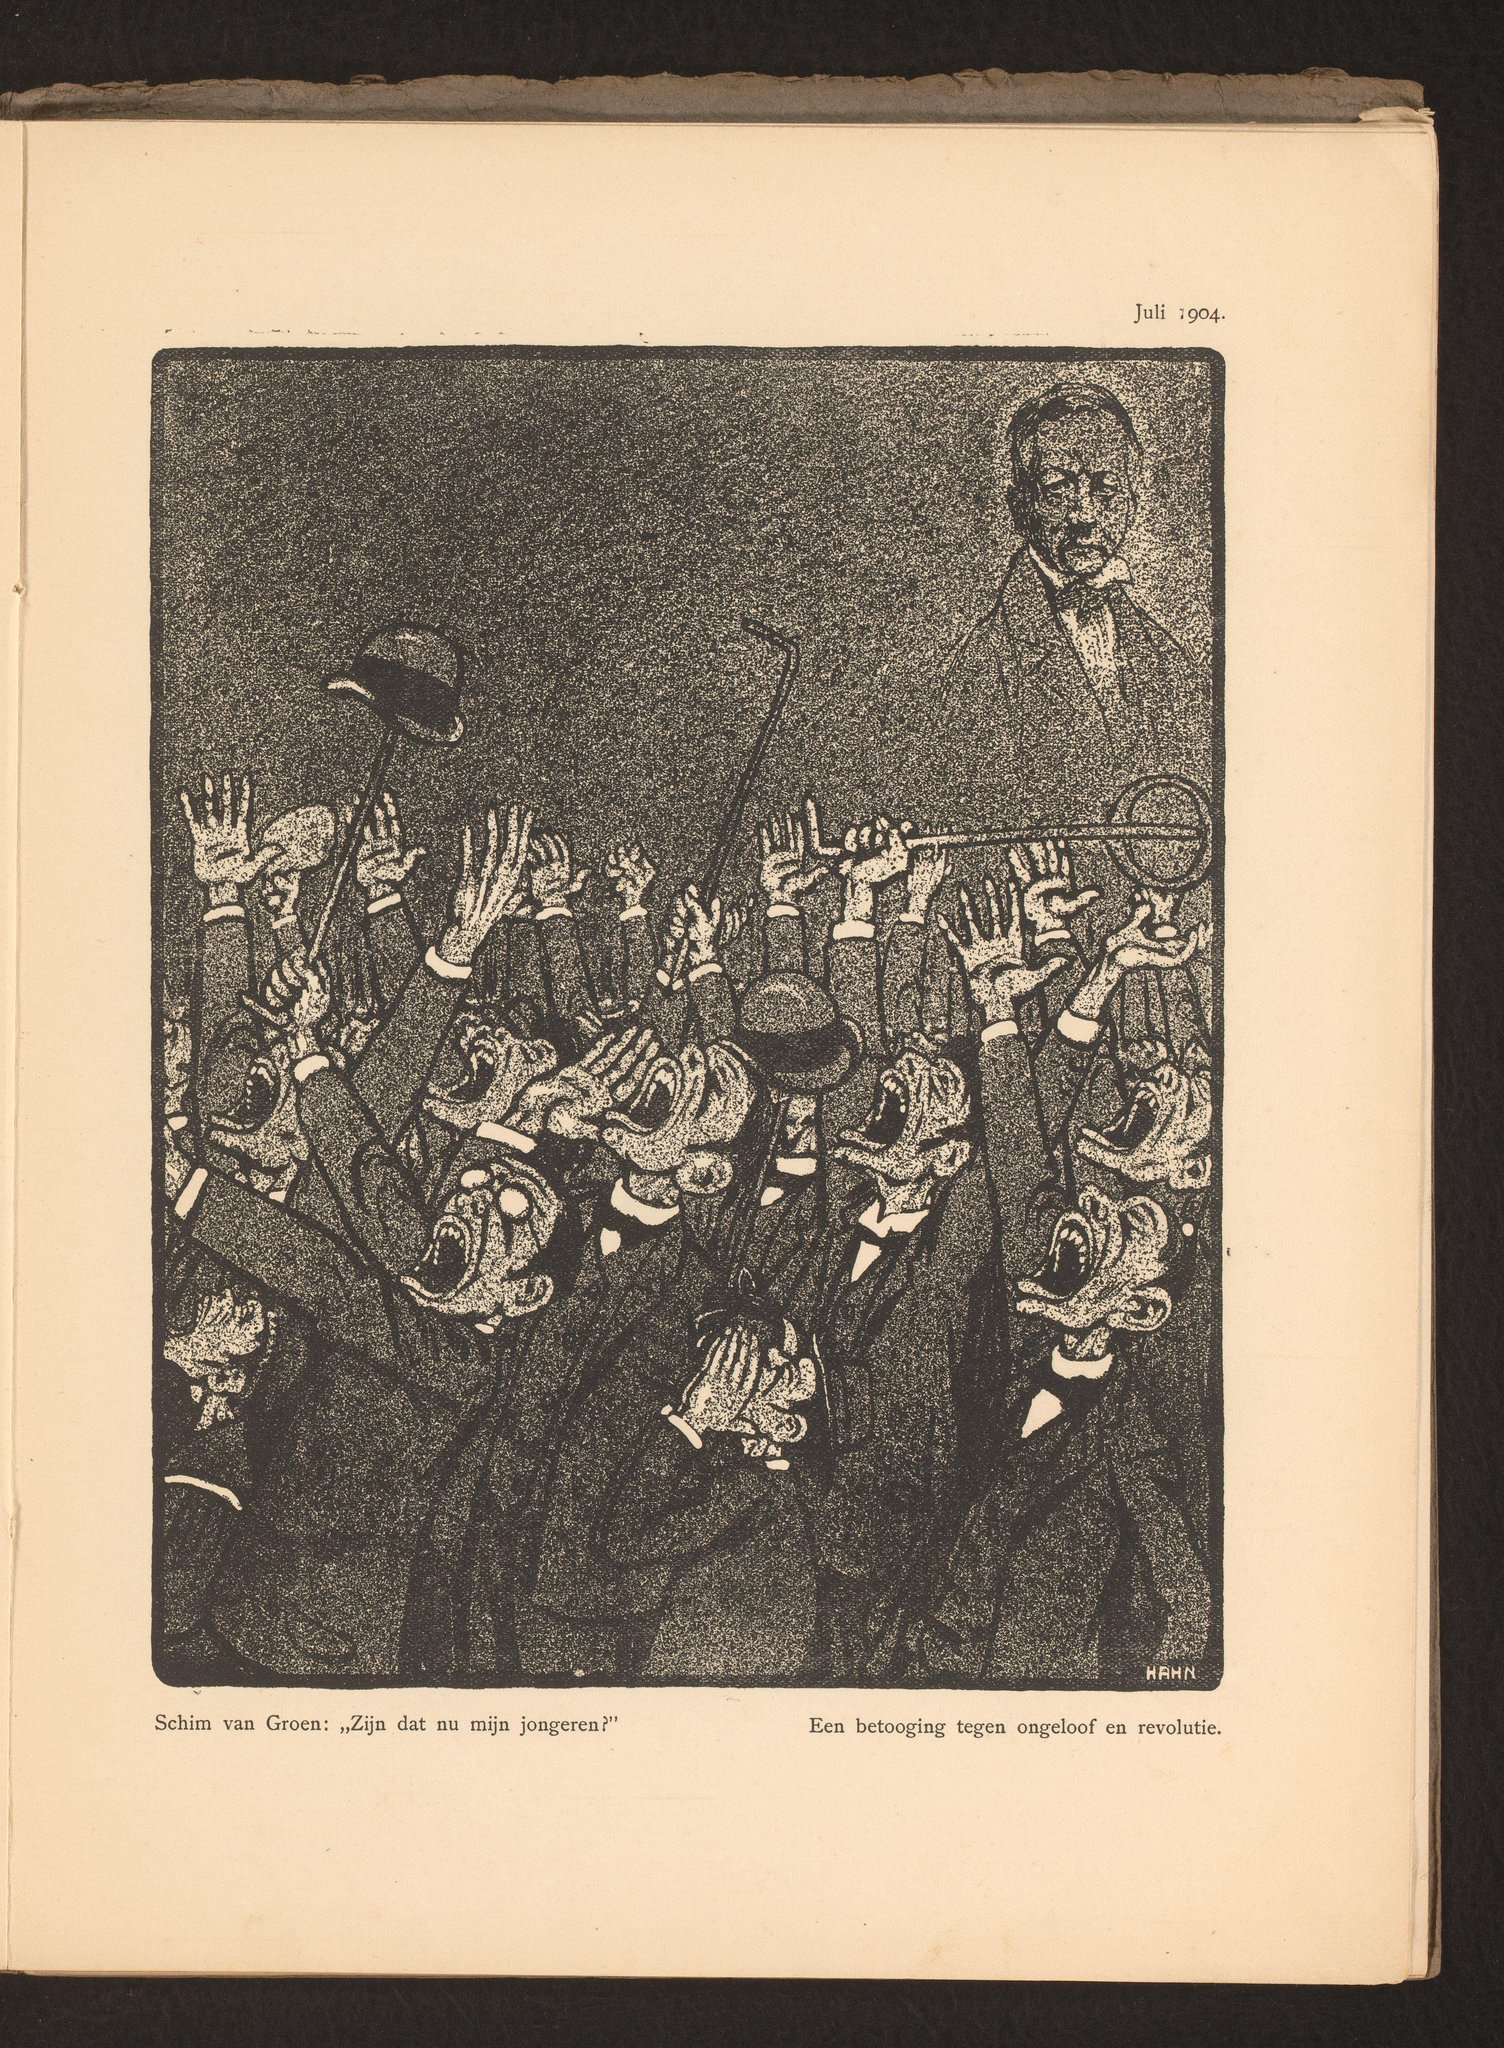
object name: photomechanical print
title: Een betooging tegen ongeloof en revolutie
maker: albert hahn (i)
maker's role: draughtsman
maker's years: 1877-1918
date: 1904-1907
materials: paper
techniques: autotype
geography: netherlands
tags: guillaume groen van prinsterer, political demonstration, political caricatures and satires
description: Een schim van Guillaume Groen van Prinsterer ziet neer op een betoging van schreeuwende mannen, juli 1904. Onderdeel van het boek 'Albert Hahn Prenten', heruitgave van een selectie politieke prenten uit de periode 1902-1906.